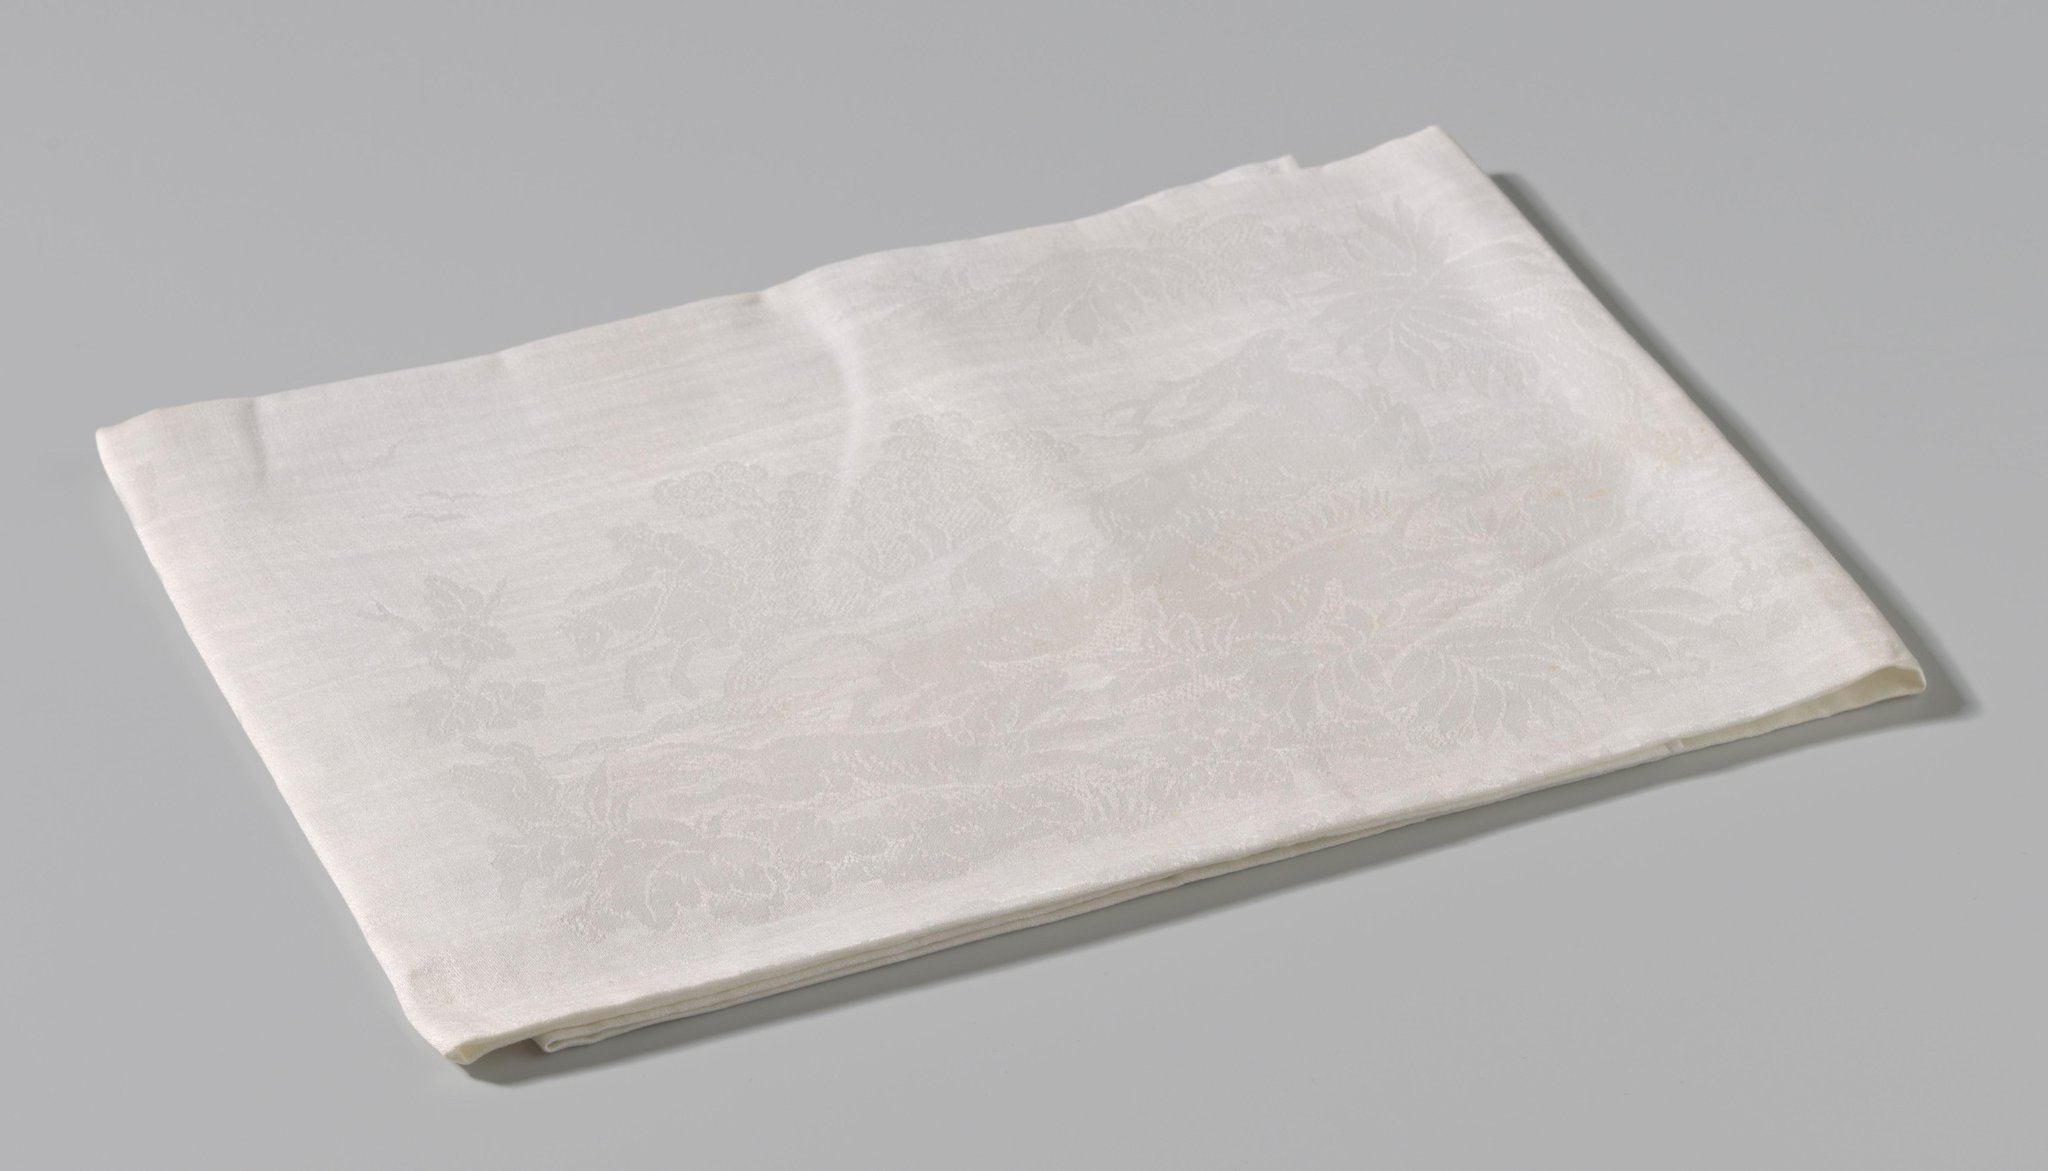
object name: napkin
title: Servet van linnendamast met een wapen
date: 1867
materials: linen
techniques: damask, weave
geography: veghel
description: Servet van linnendamast met het wapen van Schimmelpenninck. Het servet hoort bij elf servetten (BK-1973-216-A t/m BK-1973-216-L) en een tafellaken (BK-1973-215).